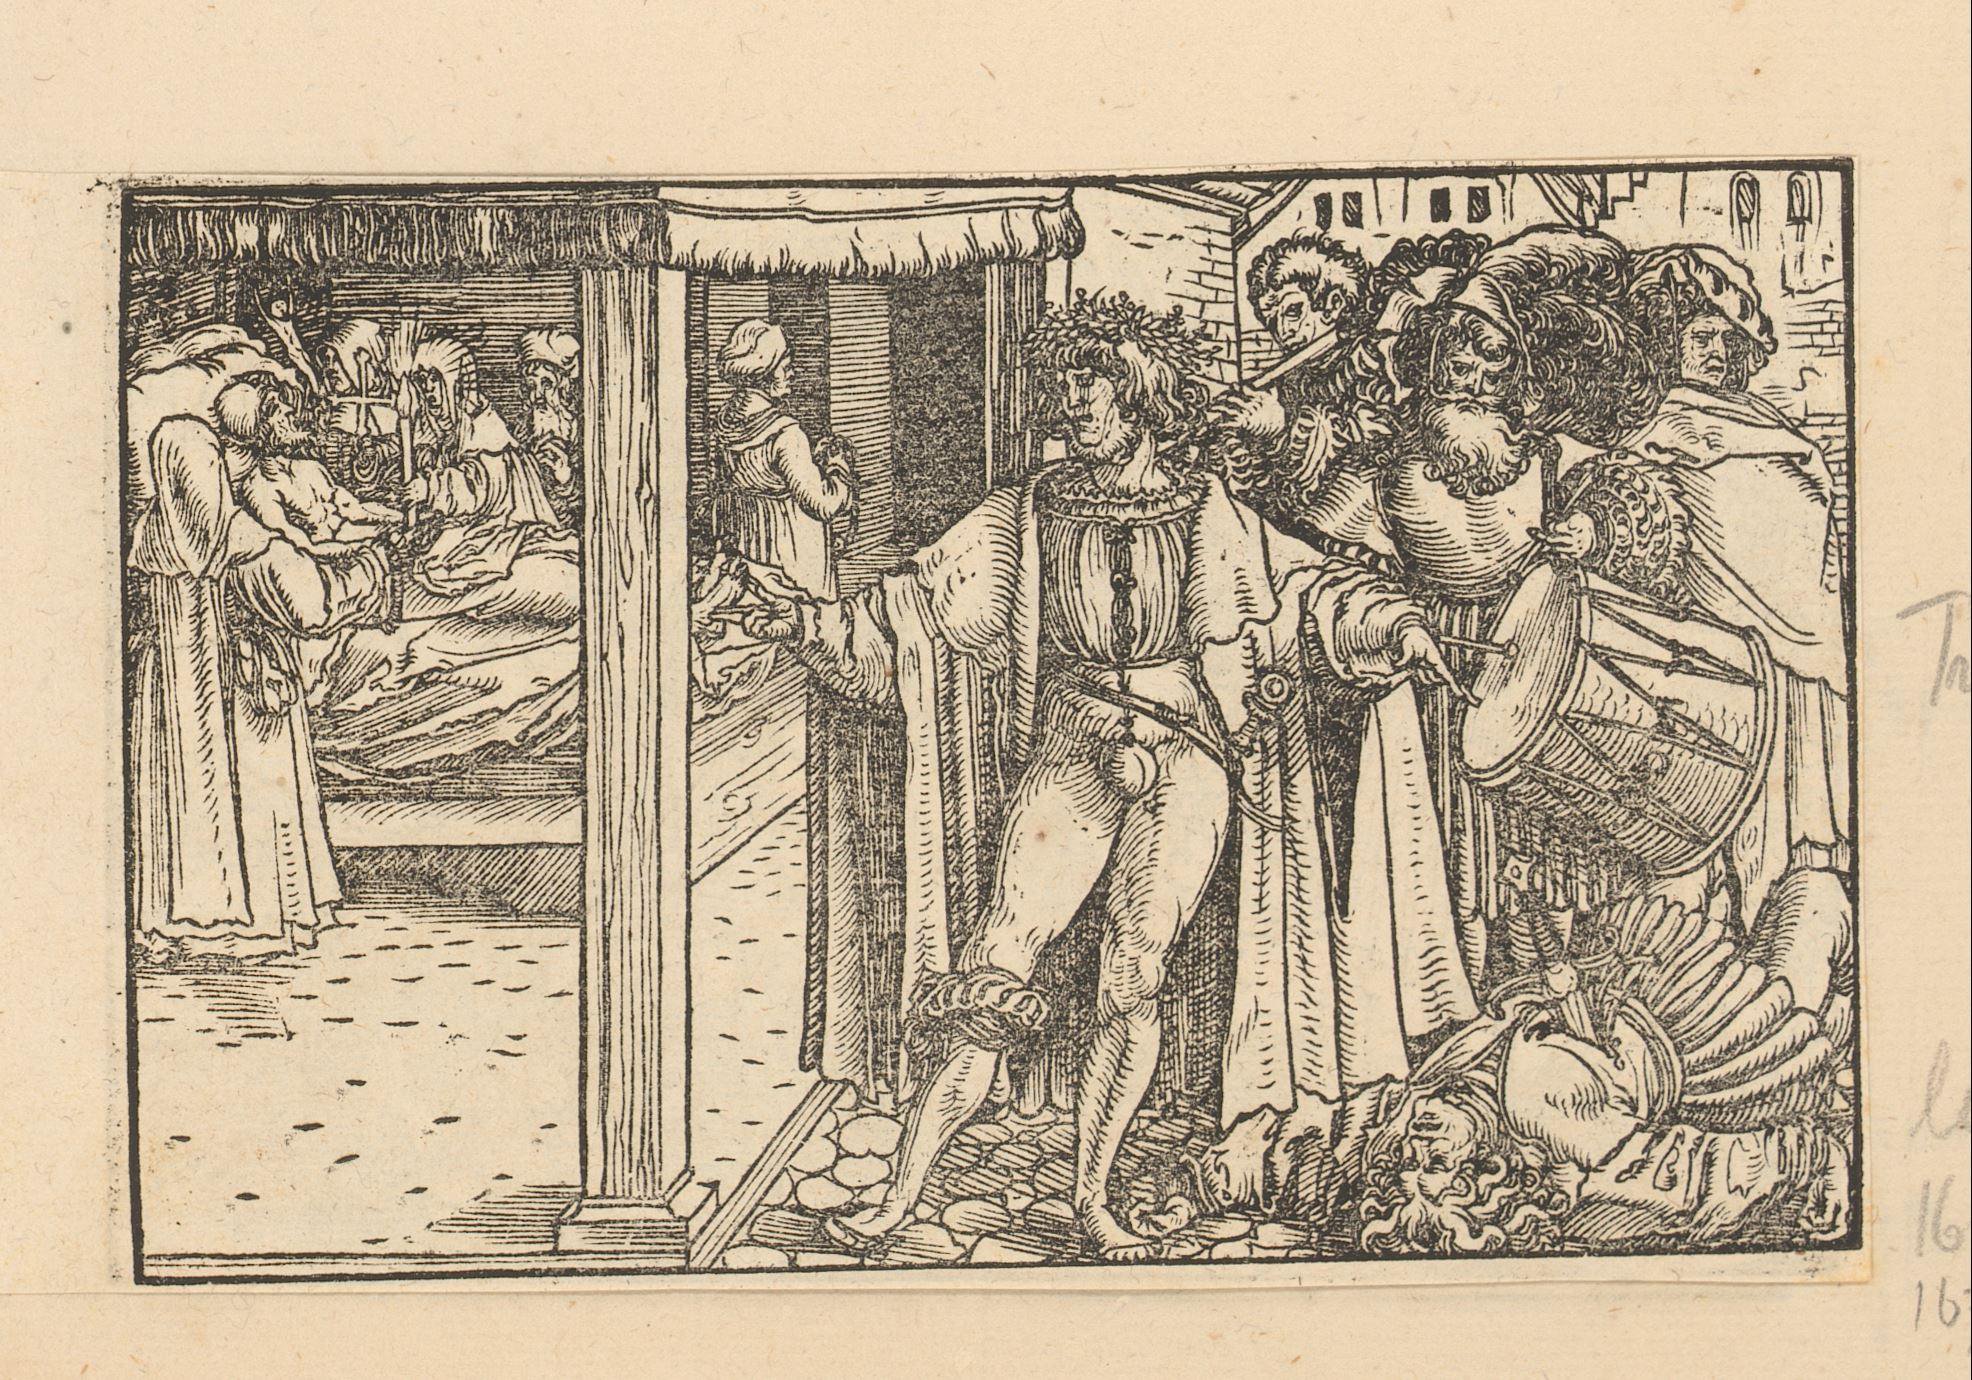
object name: album leaf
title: Sterfte en moord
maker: Anonymous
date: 1514-1532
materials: paper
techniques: letterpress printing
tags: good and bad behaviour, moral qualities, deathbed, murder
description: Deze prent is gebruikt in: Petrarca, Francesco. Von der Artzney bayder Glück, des guten und widerwertigen: unnd weß sich ain yeder inn Gelück und Unglück halten sol (...). Augsburg: Heinrich Steiner, 1532. Deze uitgave is ook bekend onder de titel 'Trostspiegel in Glück und Unglück'.